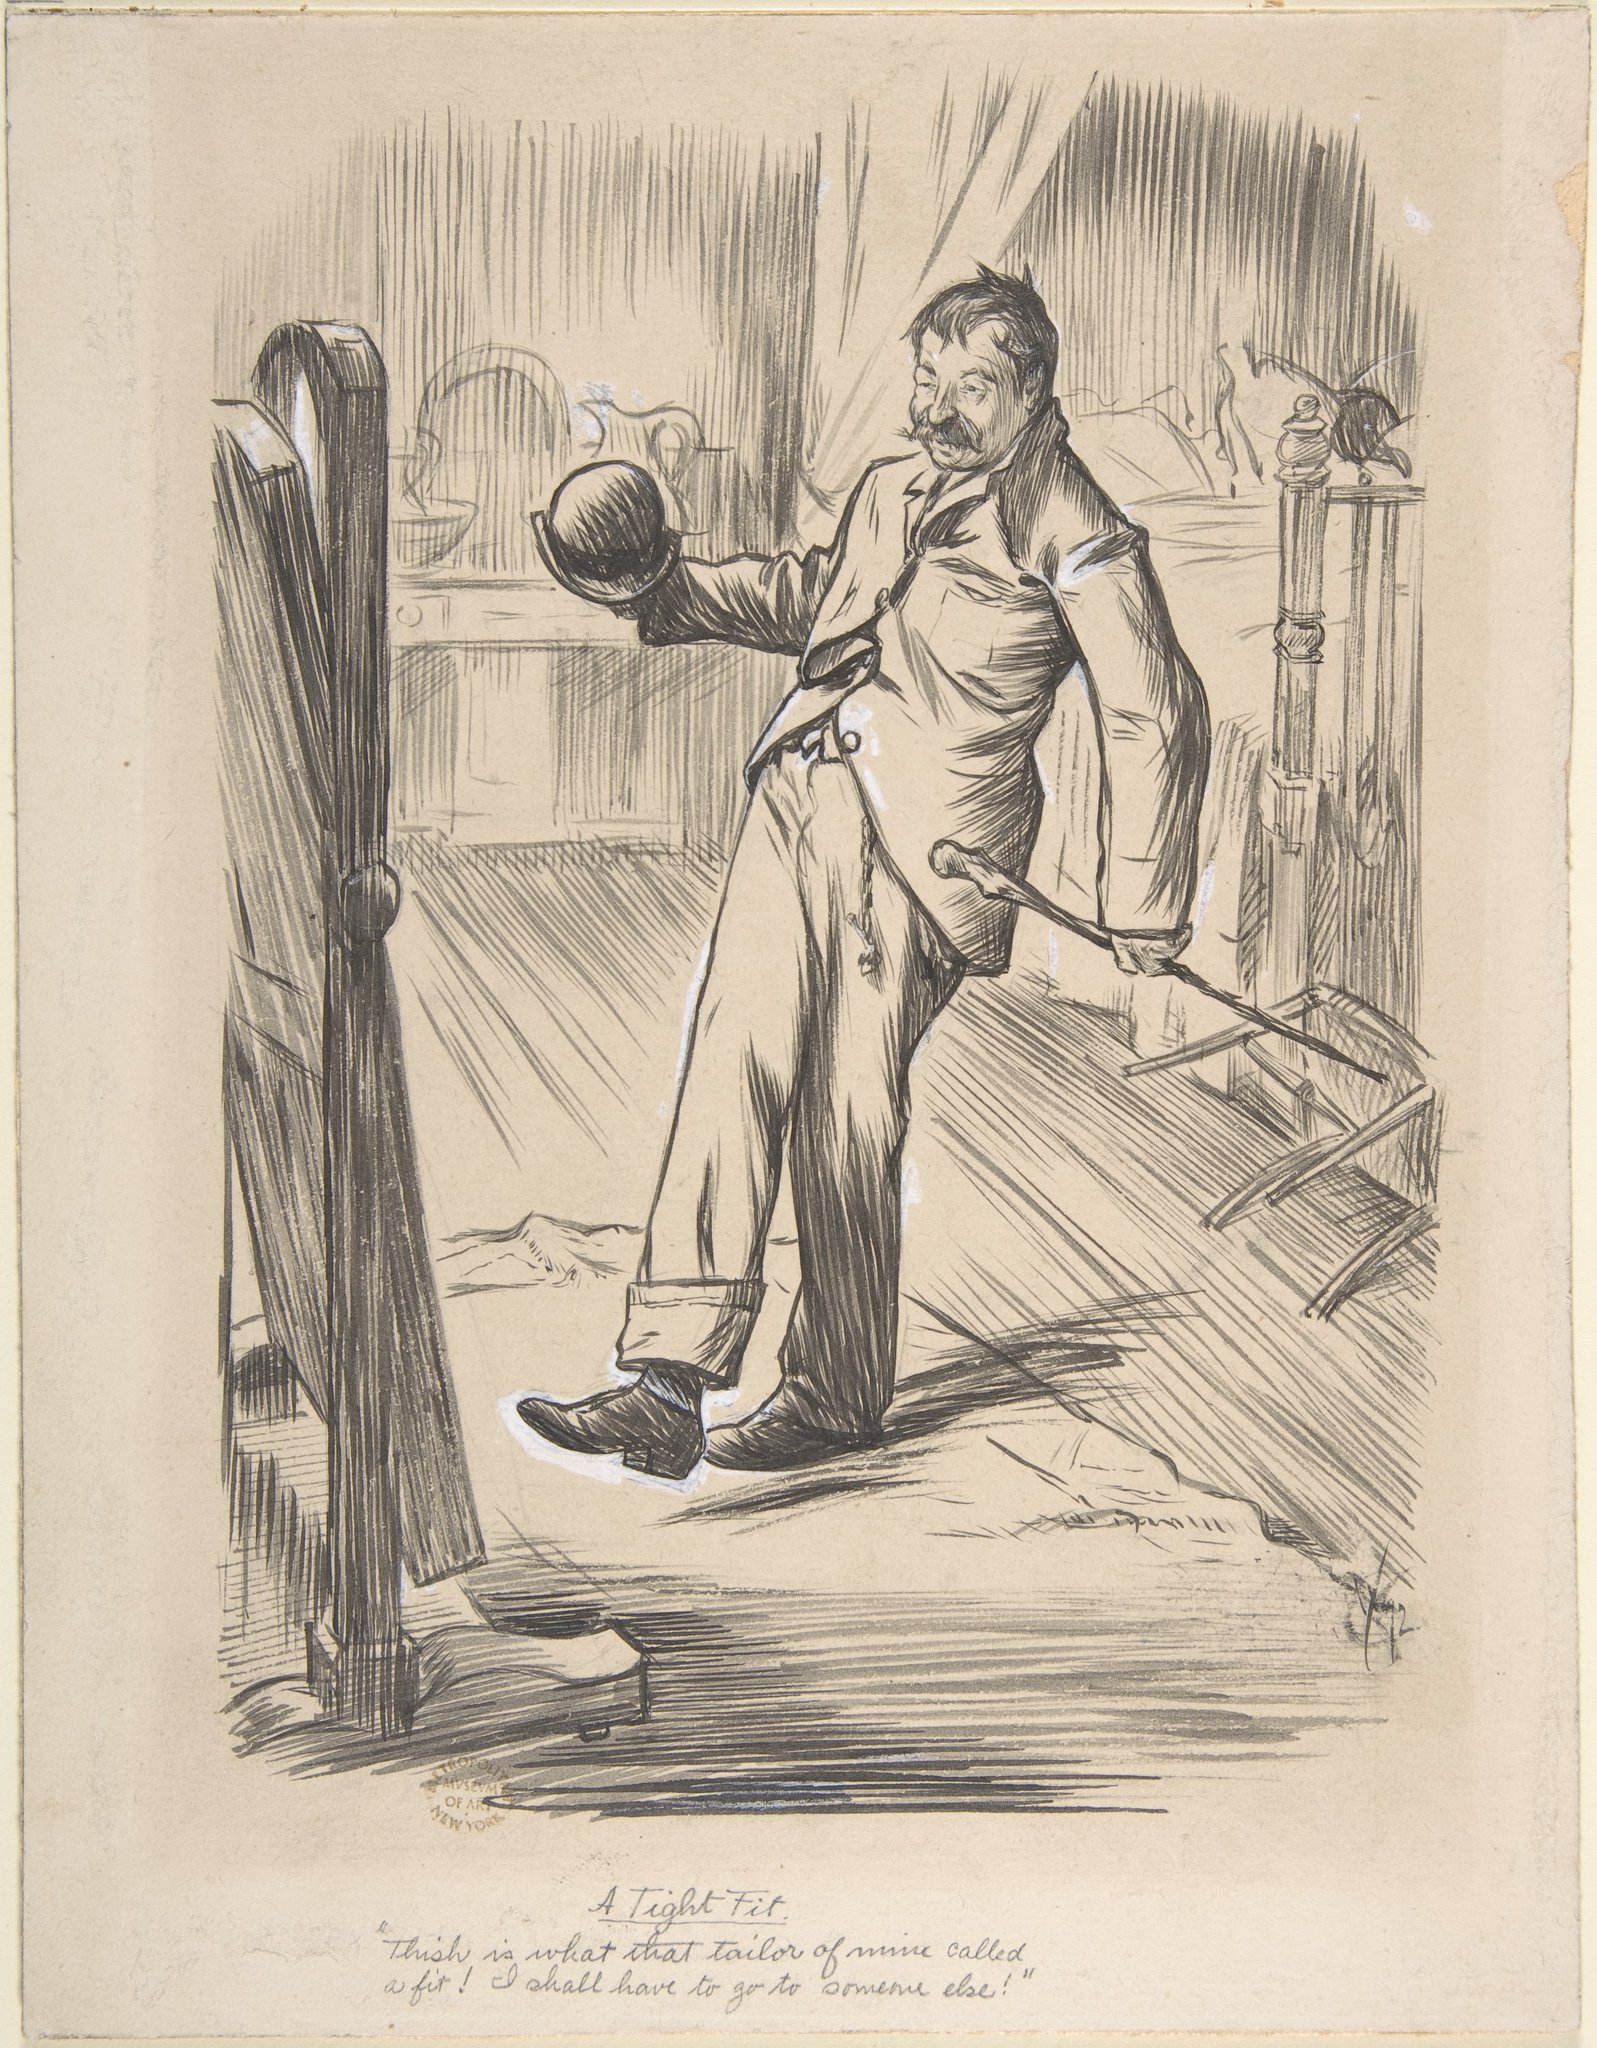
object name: drawing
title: "A Tight Fit"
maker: charles samuel keene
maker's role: artist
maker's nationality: british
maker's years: 1823-1891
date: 1872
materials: gouache, ink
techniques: brush, pen, wash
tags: satire,bedrooms,men